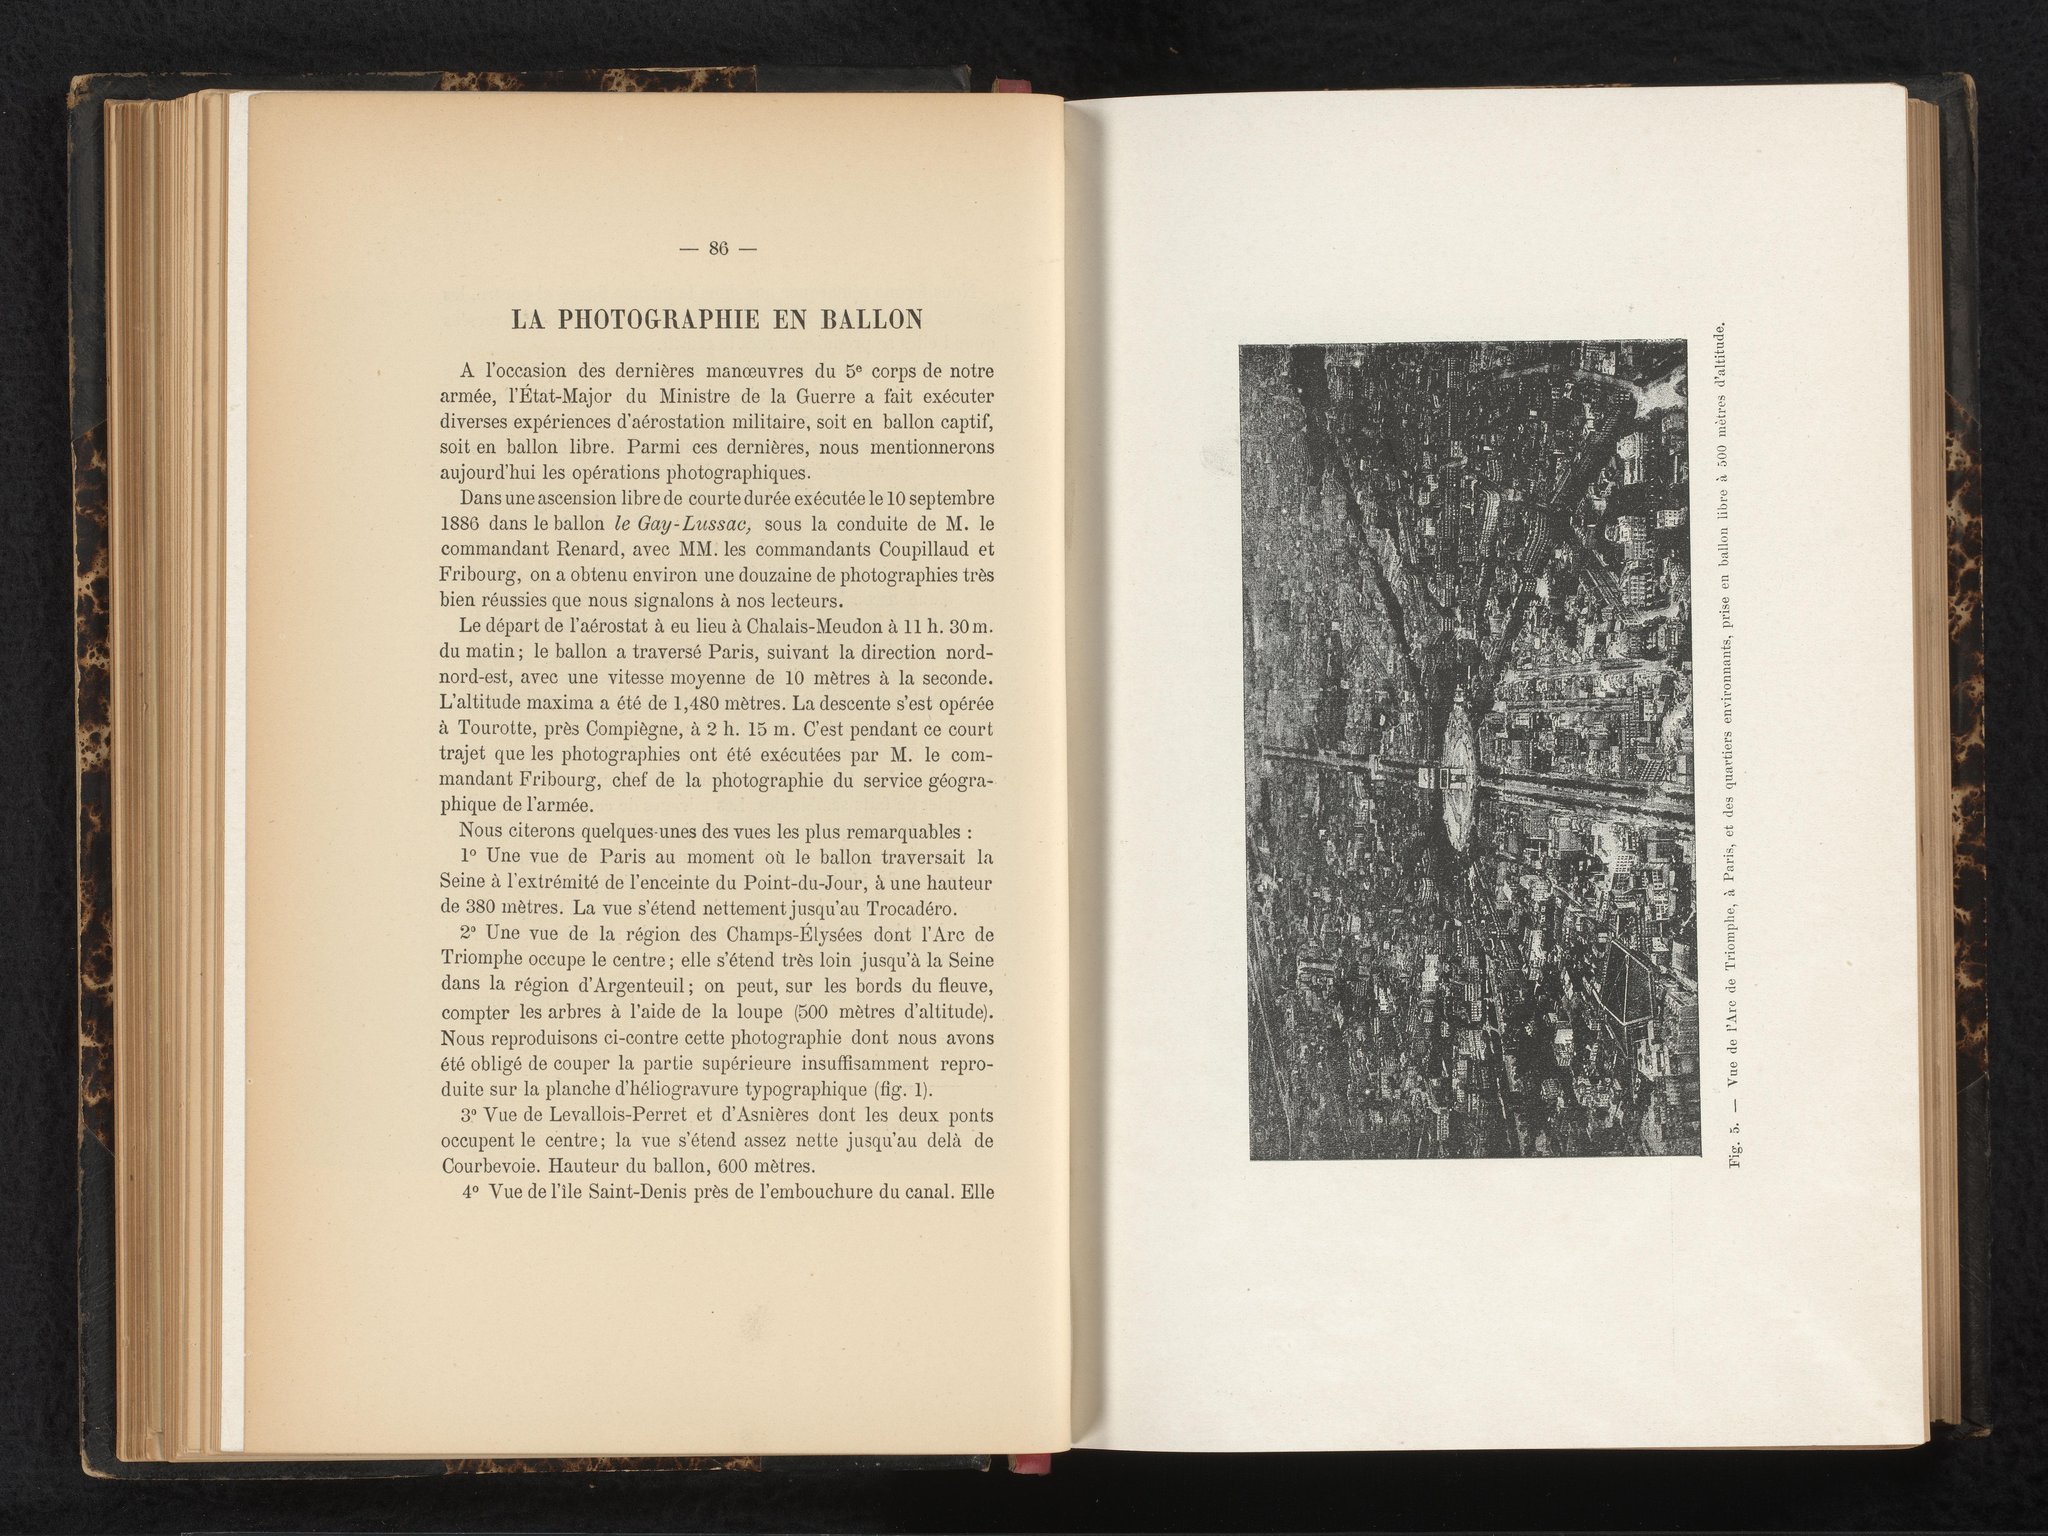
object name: photomechanical print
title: Vue de l'Arc de Triomphe, à Paris, et des quartiers environnants, prise en ballon libre à 500 mètres d'altitude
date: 1886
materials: paper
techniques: photoaquatint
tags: square, place, circus, etc., city-view in general; 'veduta'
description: Prent op ongenummerde pagina tegenover pagina 86.